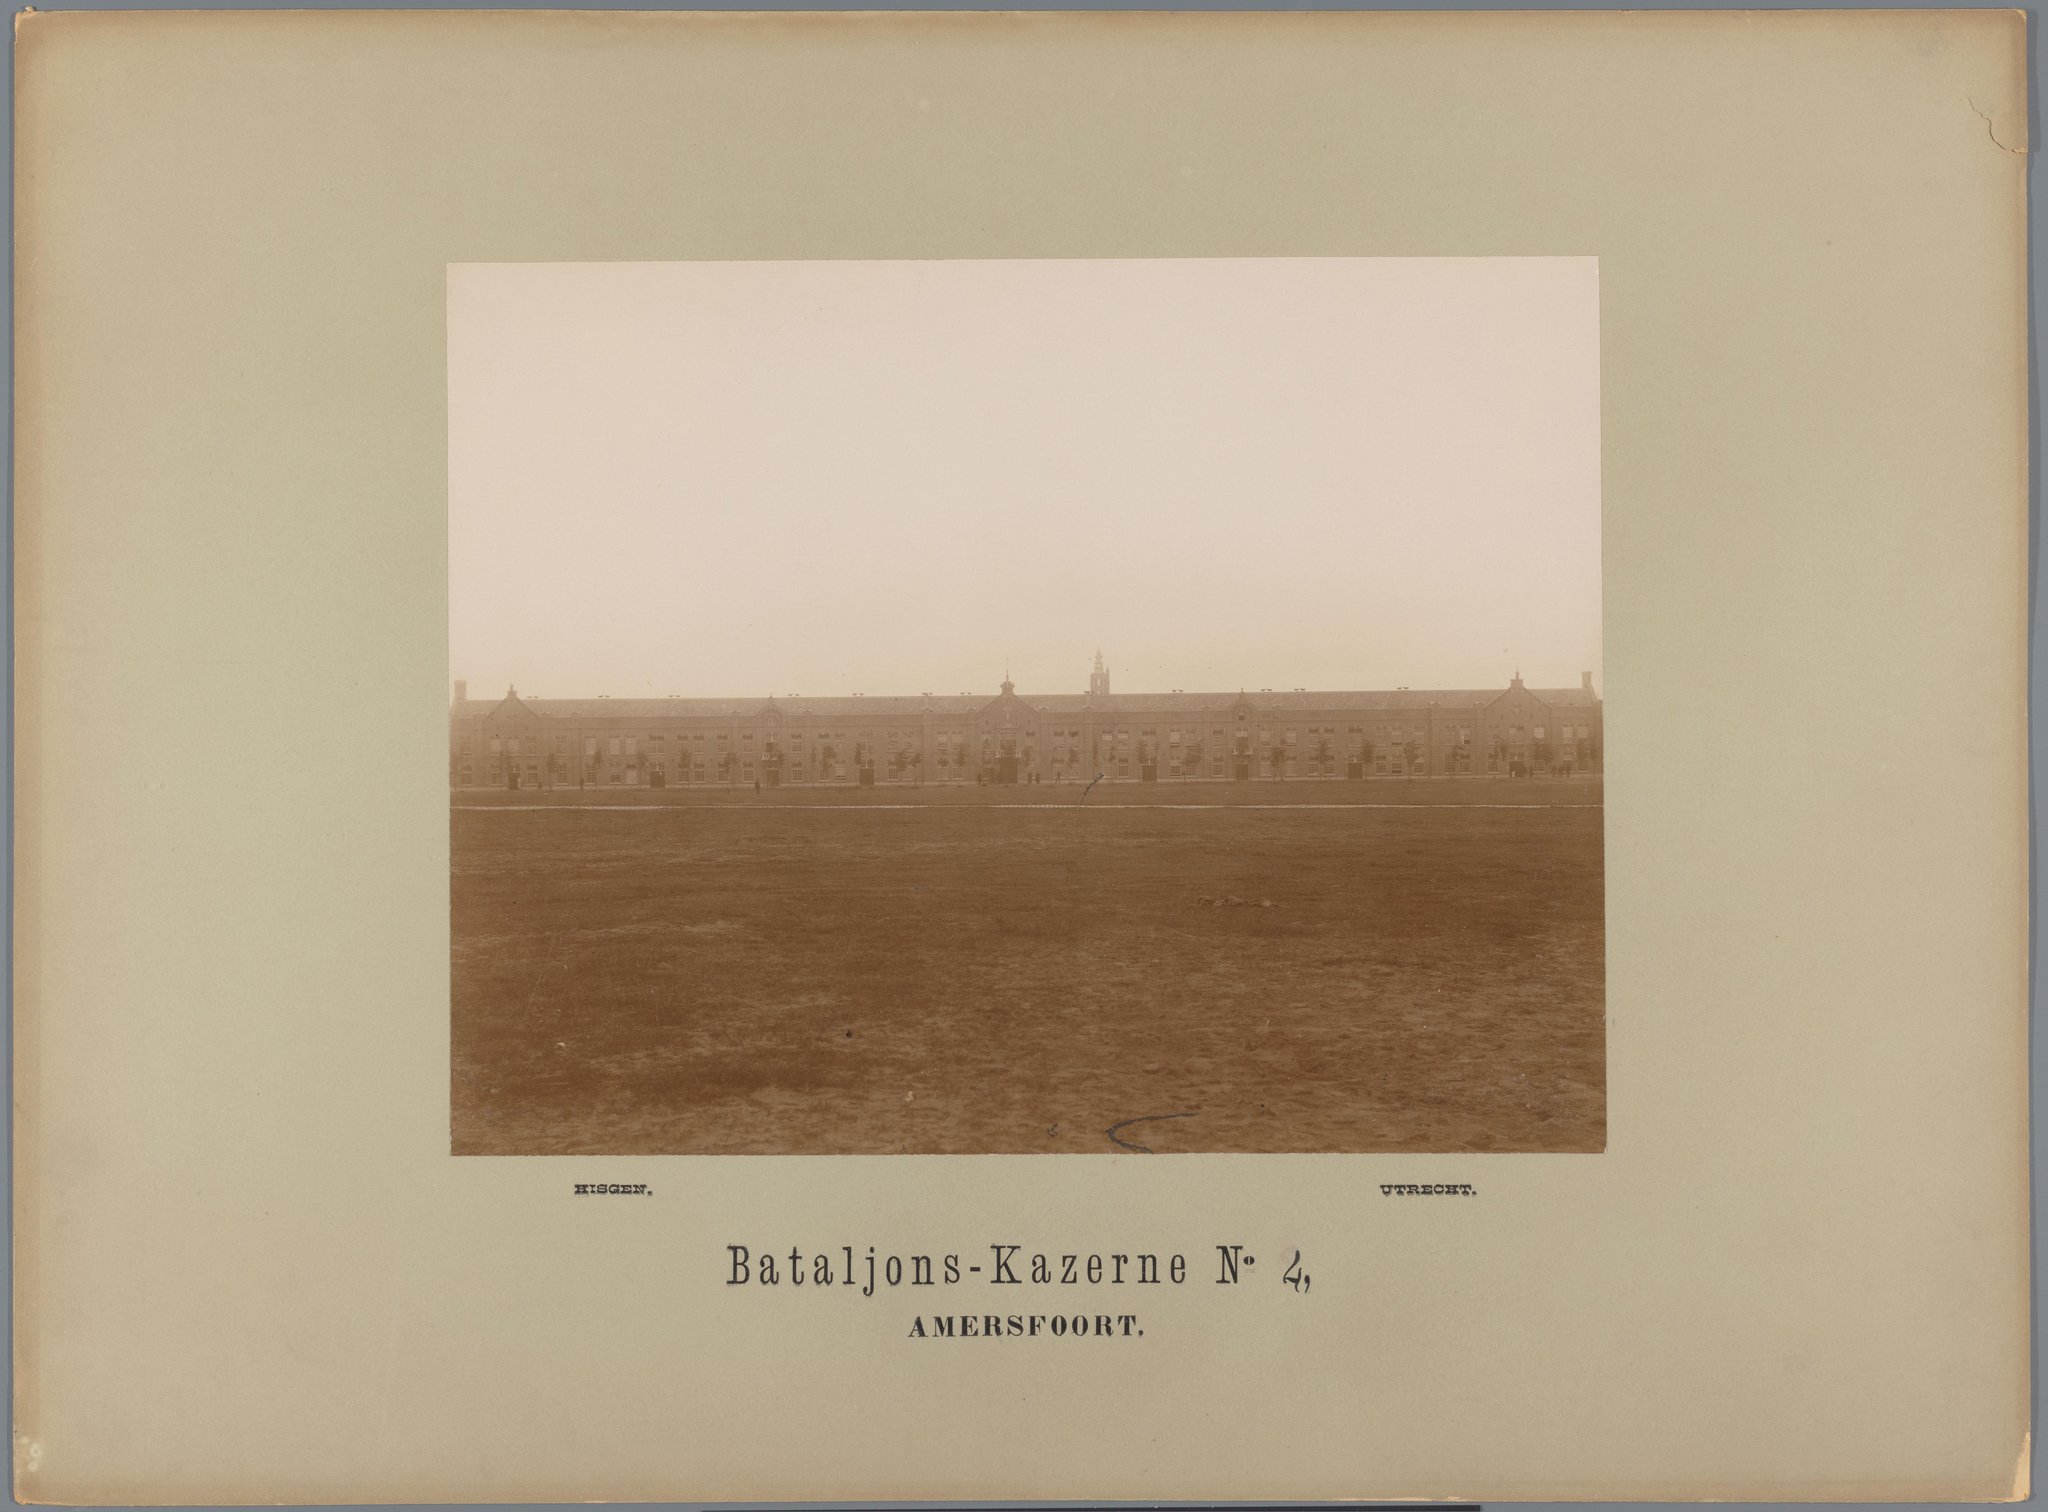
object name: photograph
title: Bataljons kazerne No. 4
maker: carel gustaaf hisgen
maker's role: fotograaf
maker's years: 1852-1917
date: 1893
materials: cardboard, paper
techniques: photography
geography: amersfoort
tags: netherlands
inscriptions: date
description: Foto, geelbruin, op karton, met boven titel en onder omschrijving. Opschrift; m.o.: Bataljons-Kazerne No 4.